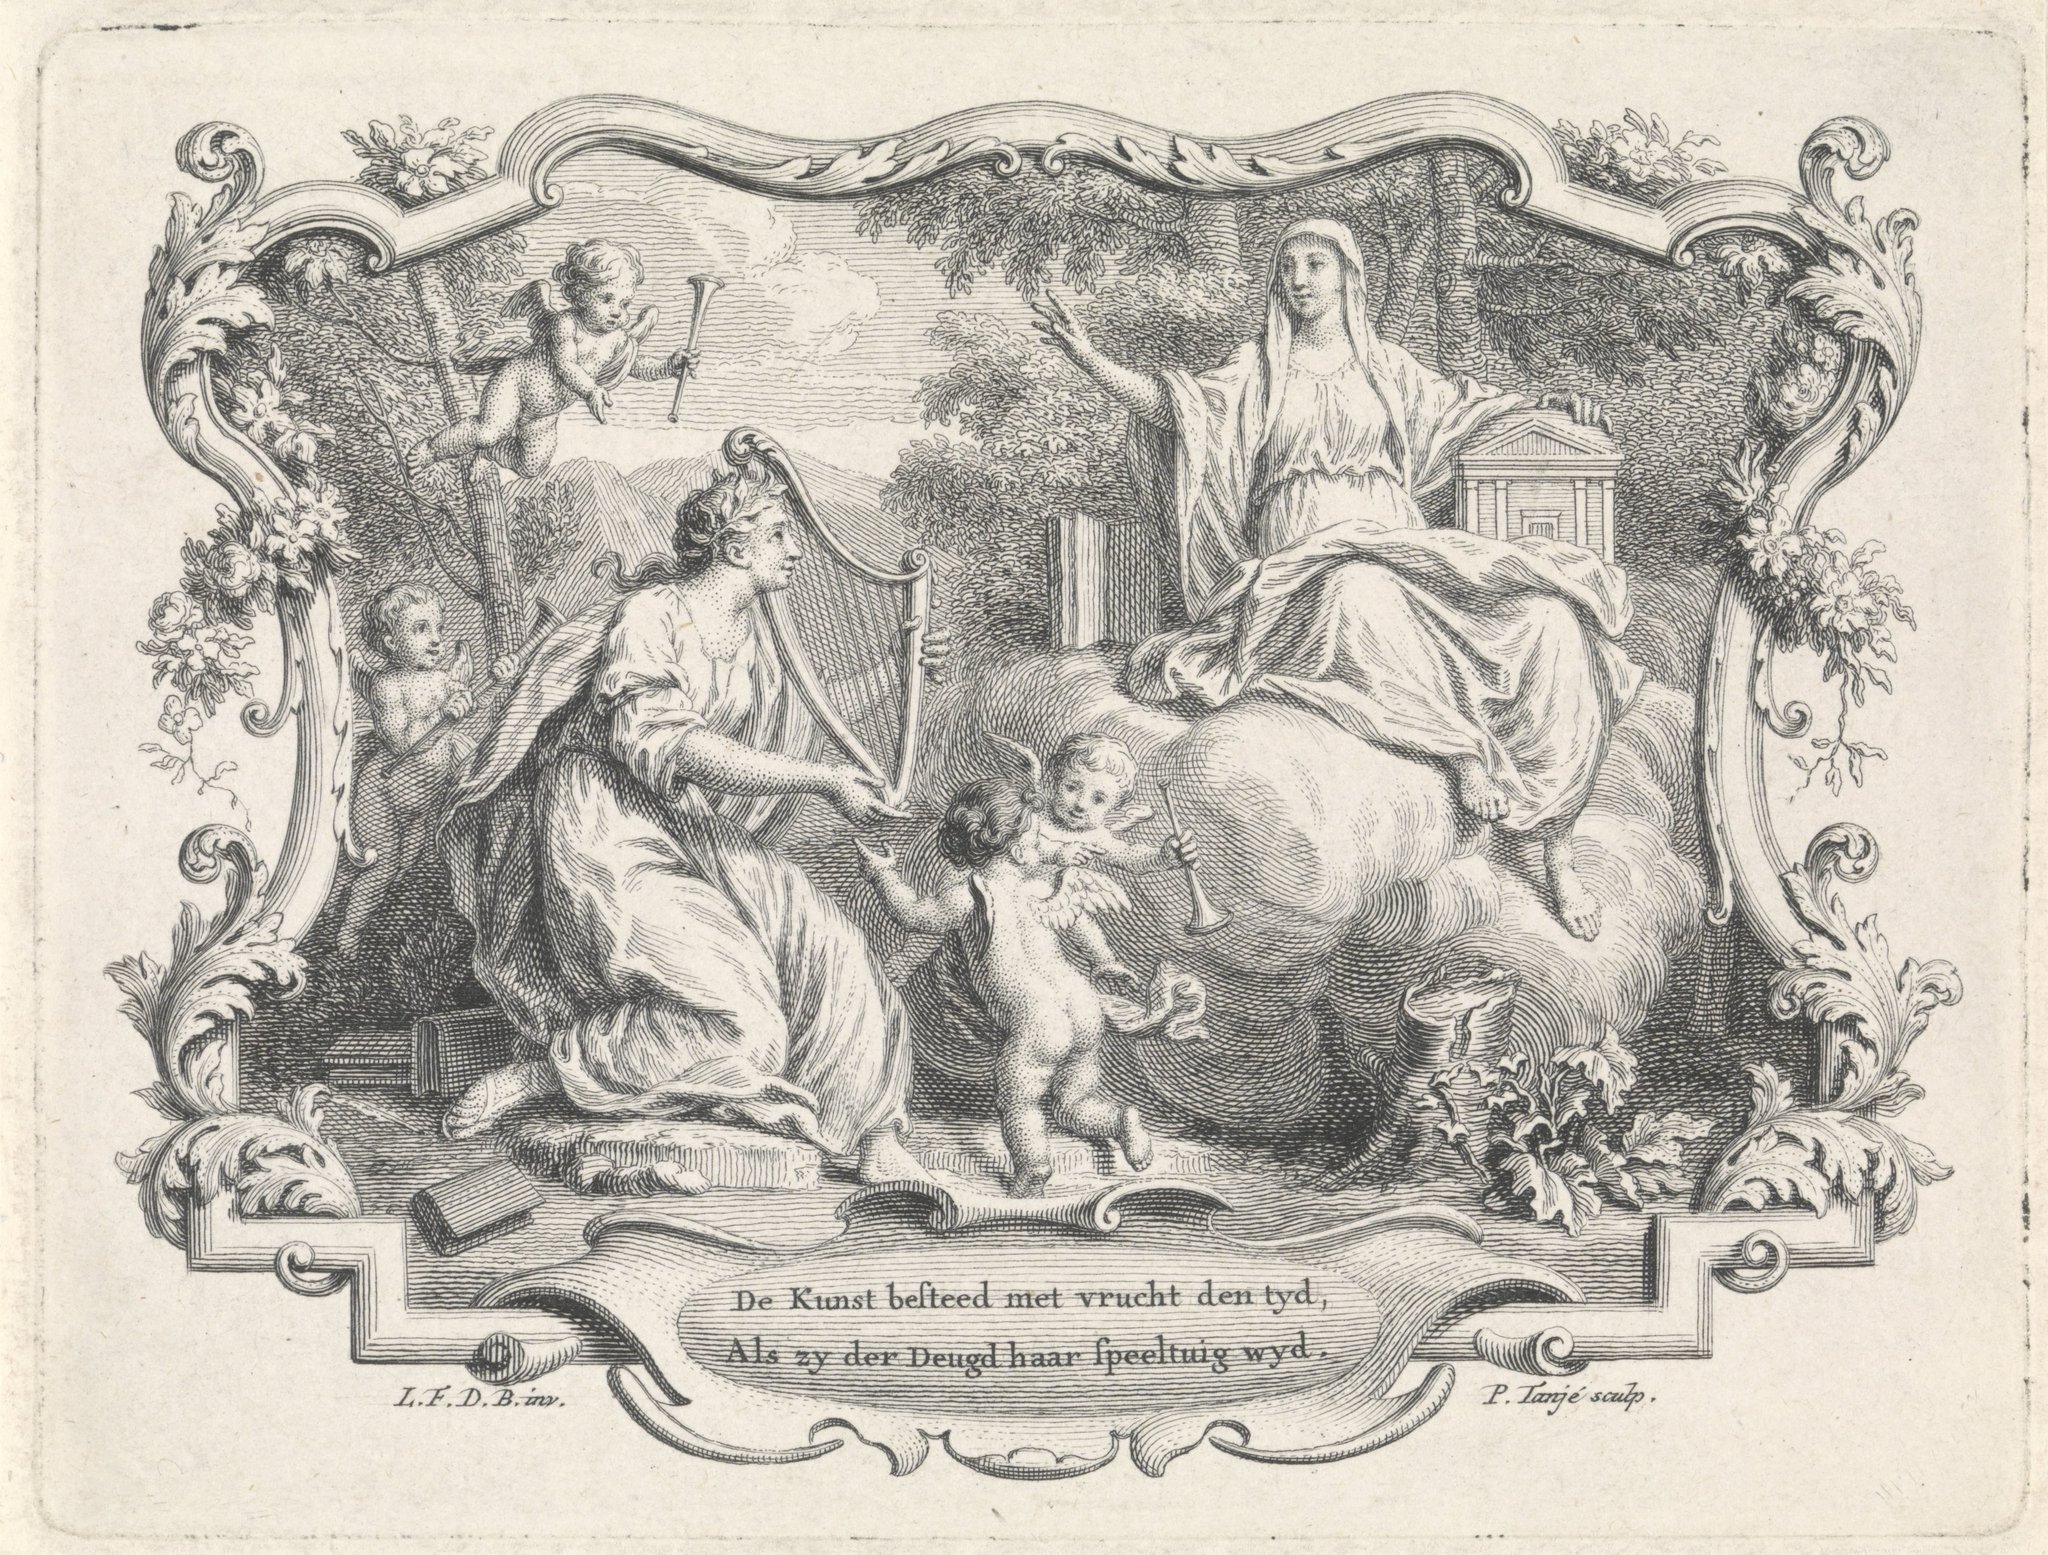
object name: print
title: Kunst kijkt op naar Deugd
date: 1716-1761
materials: paper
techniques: engraving, etching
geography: amsterdam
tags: temple of 'sapientia', with seven columns (+ variant), symbolic representations, allegories and emblems ~ art; 'arte' (ripa), 'sapientia', mother of the seven virtues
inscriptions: collector's mark: Lugt 240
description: Cartouche met de Kunst, die met een harp in de hand, opkijkt naar de Deugd. De boodschap van de voorstelling is dat de Kunst haar tijd goed gebruikt als zij zich met de Deugd bezighoudt.